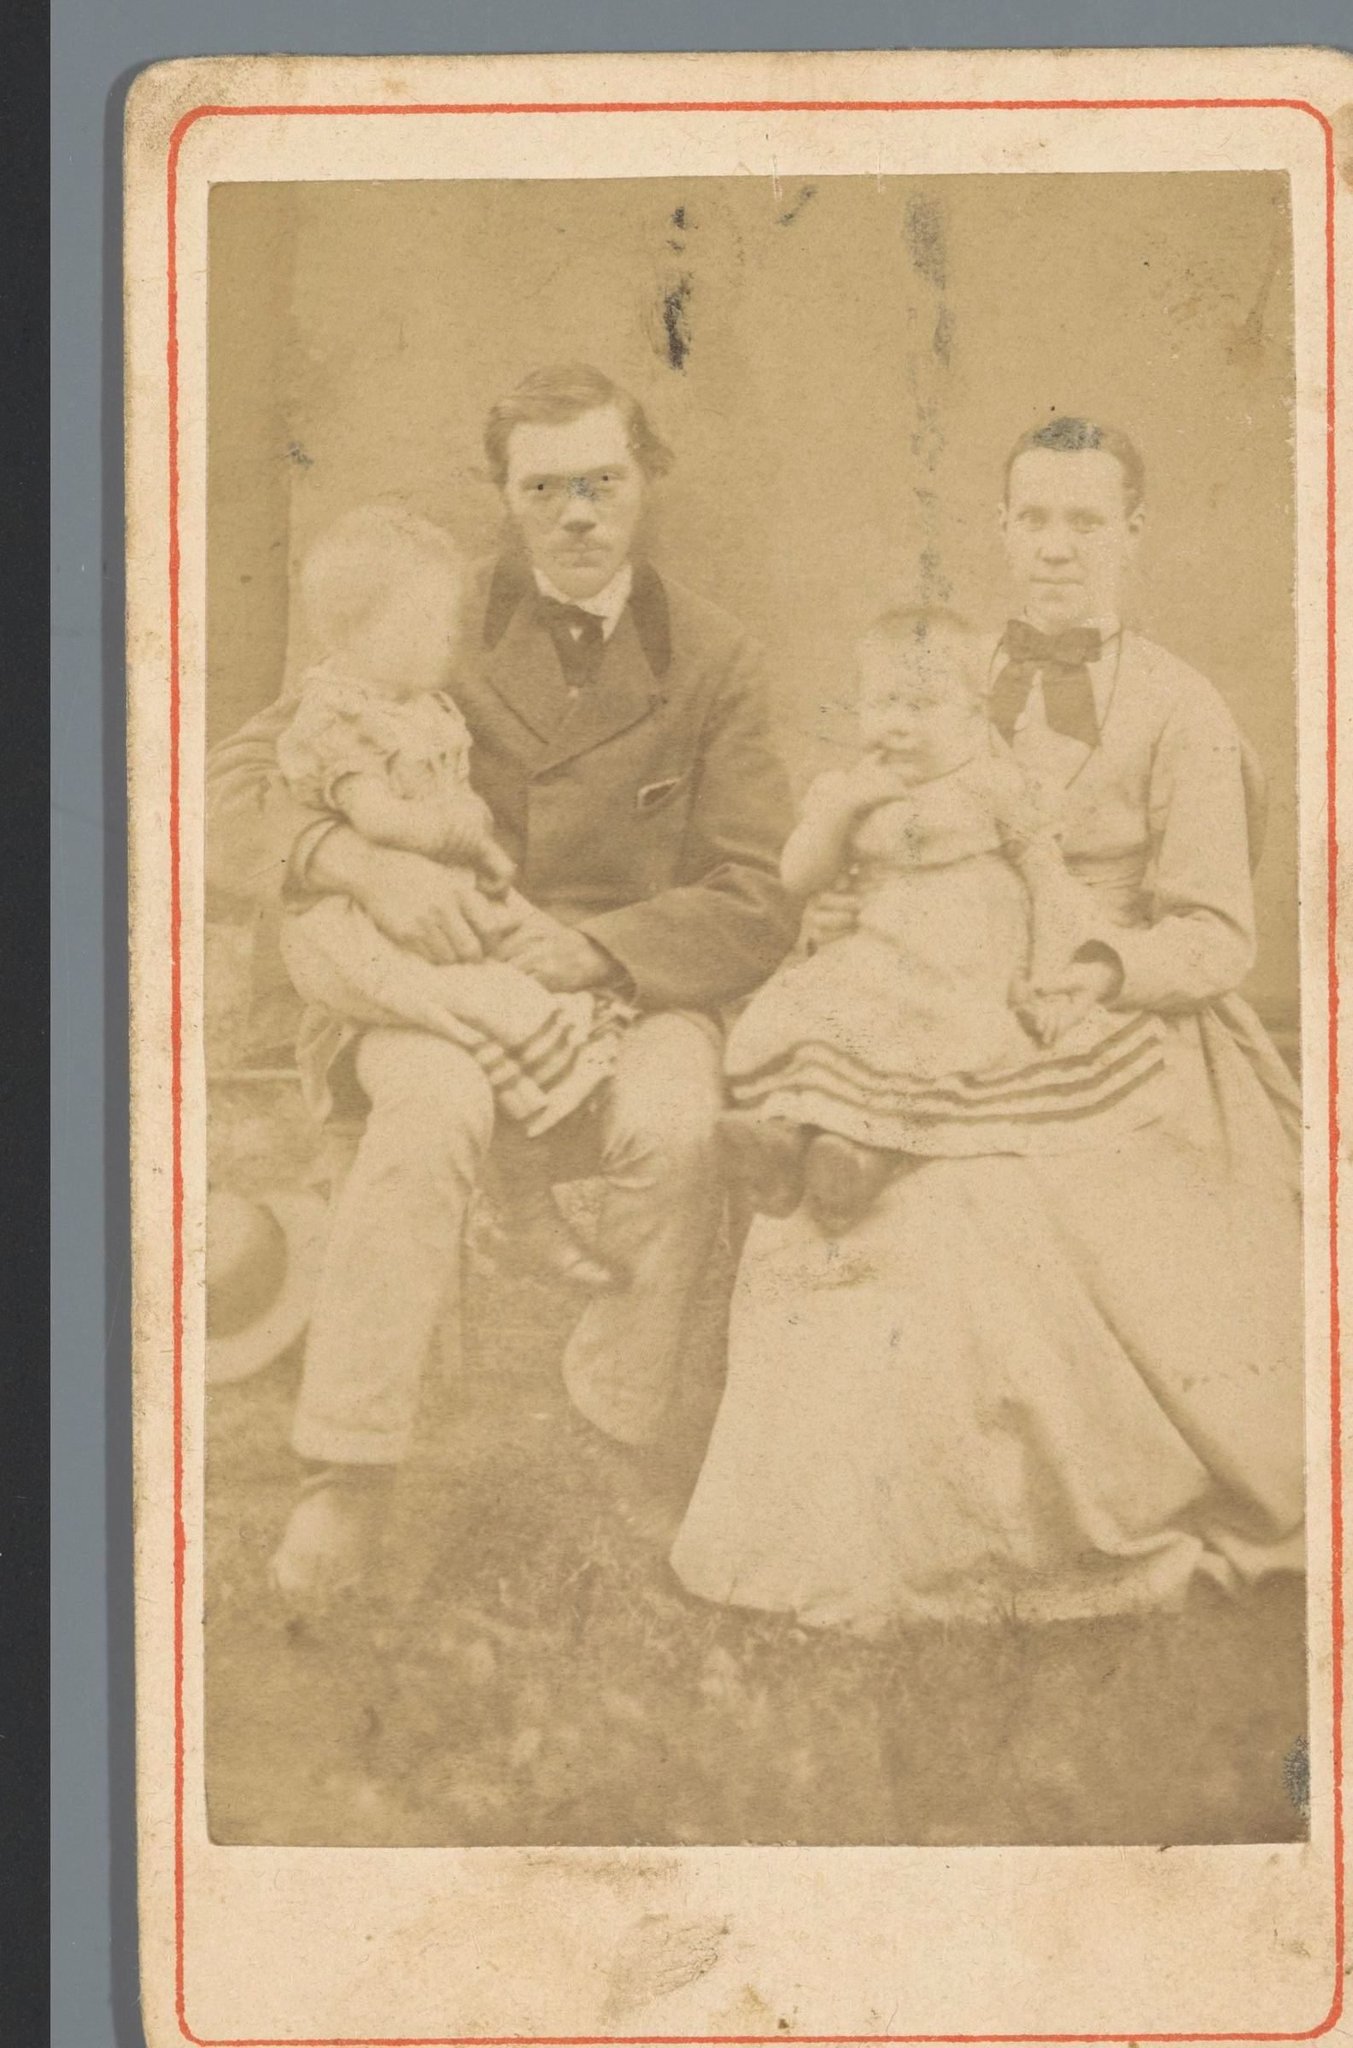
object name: photograph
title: Groepsportret van een gezin met twee kinderen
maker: Anonymous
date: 1854-1885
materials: cardboard, paper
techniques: albumen print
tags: family, relationship, descent, anonymous historical persons portrayed in a group, in a group-portrait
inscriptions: inscription: ‘[...]’